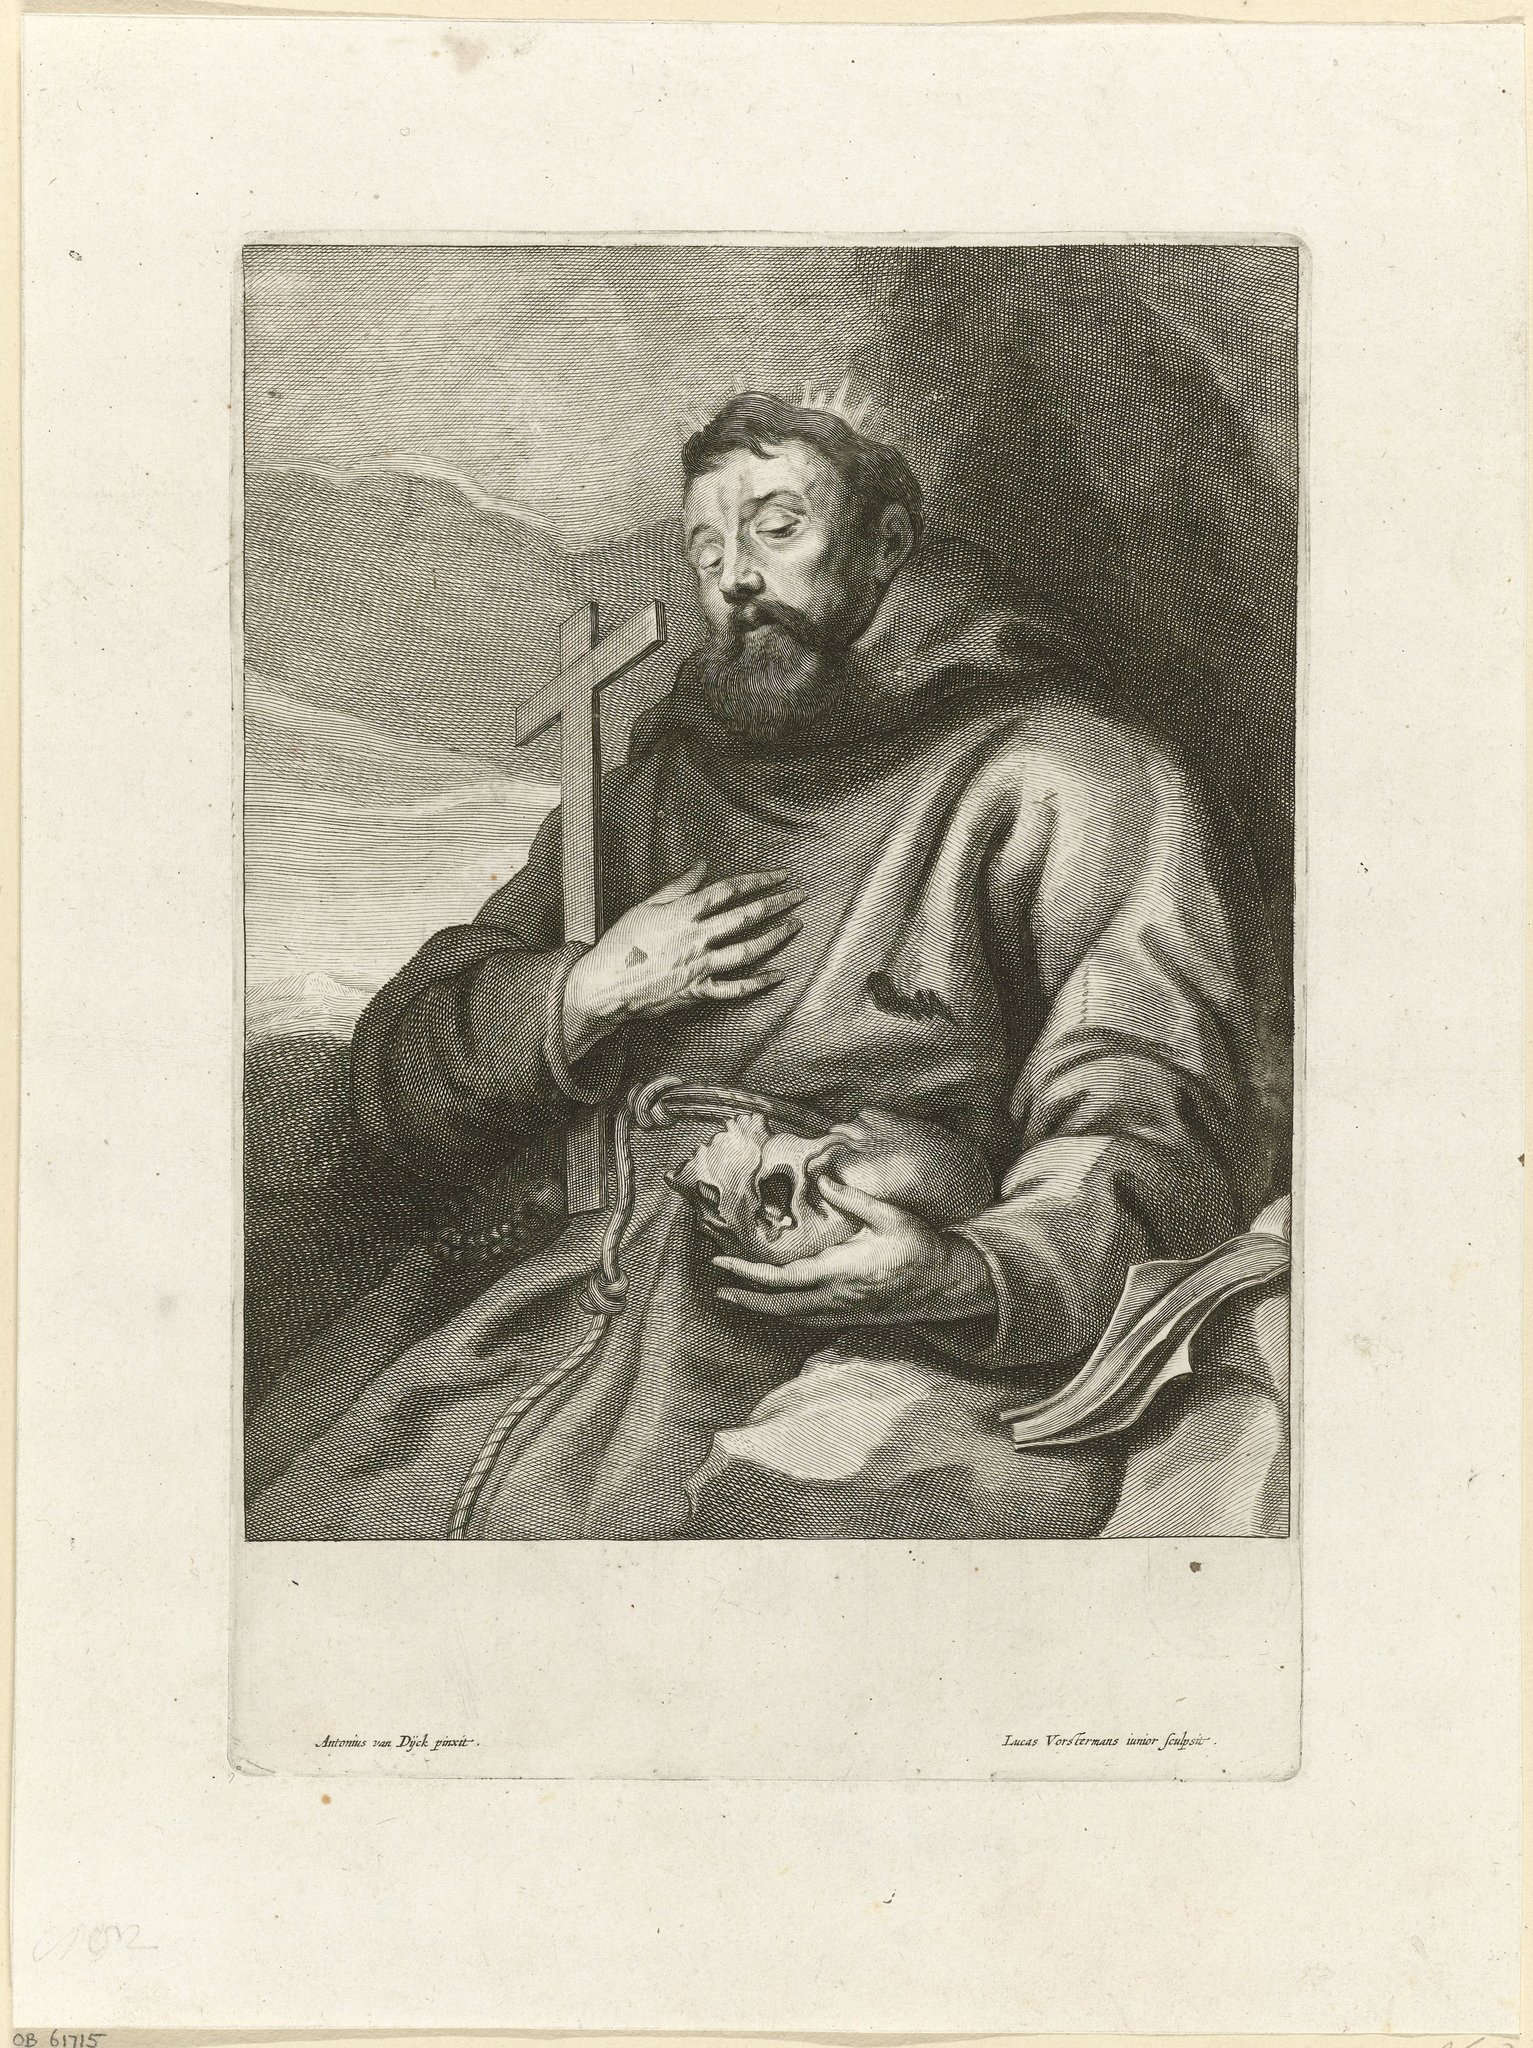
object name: print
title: H. Franciscus van Assissi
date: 1651-1652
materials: paper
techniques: engraving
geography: antwerp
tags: founder of the order of friars minor (franciscans), francis(cus) of assisi; possible attributes: book, crucifix, lily, skull, stigmata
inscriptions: collector's mark: Lugt 240